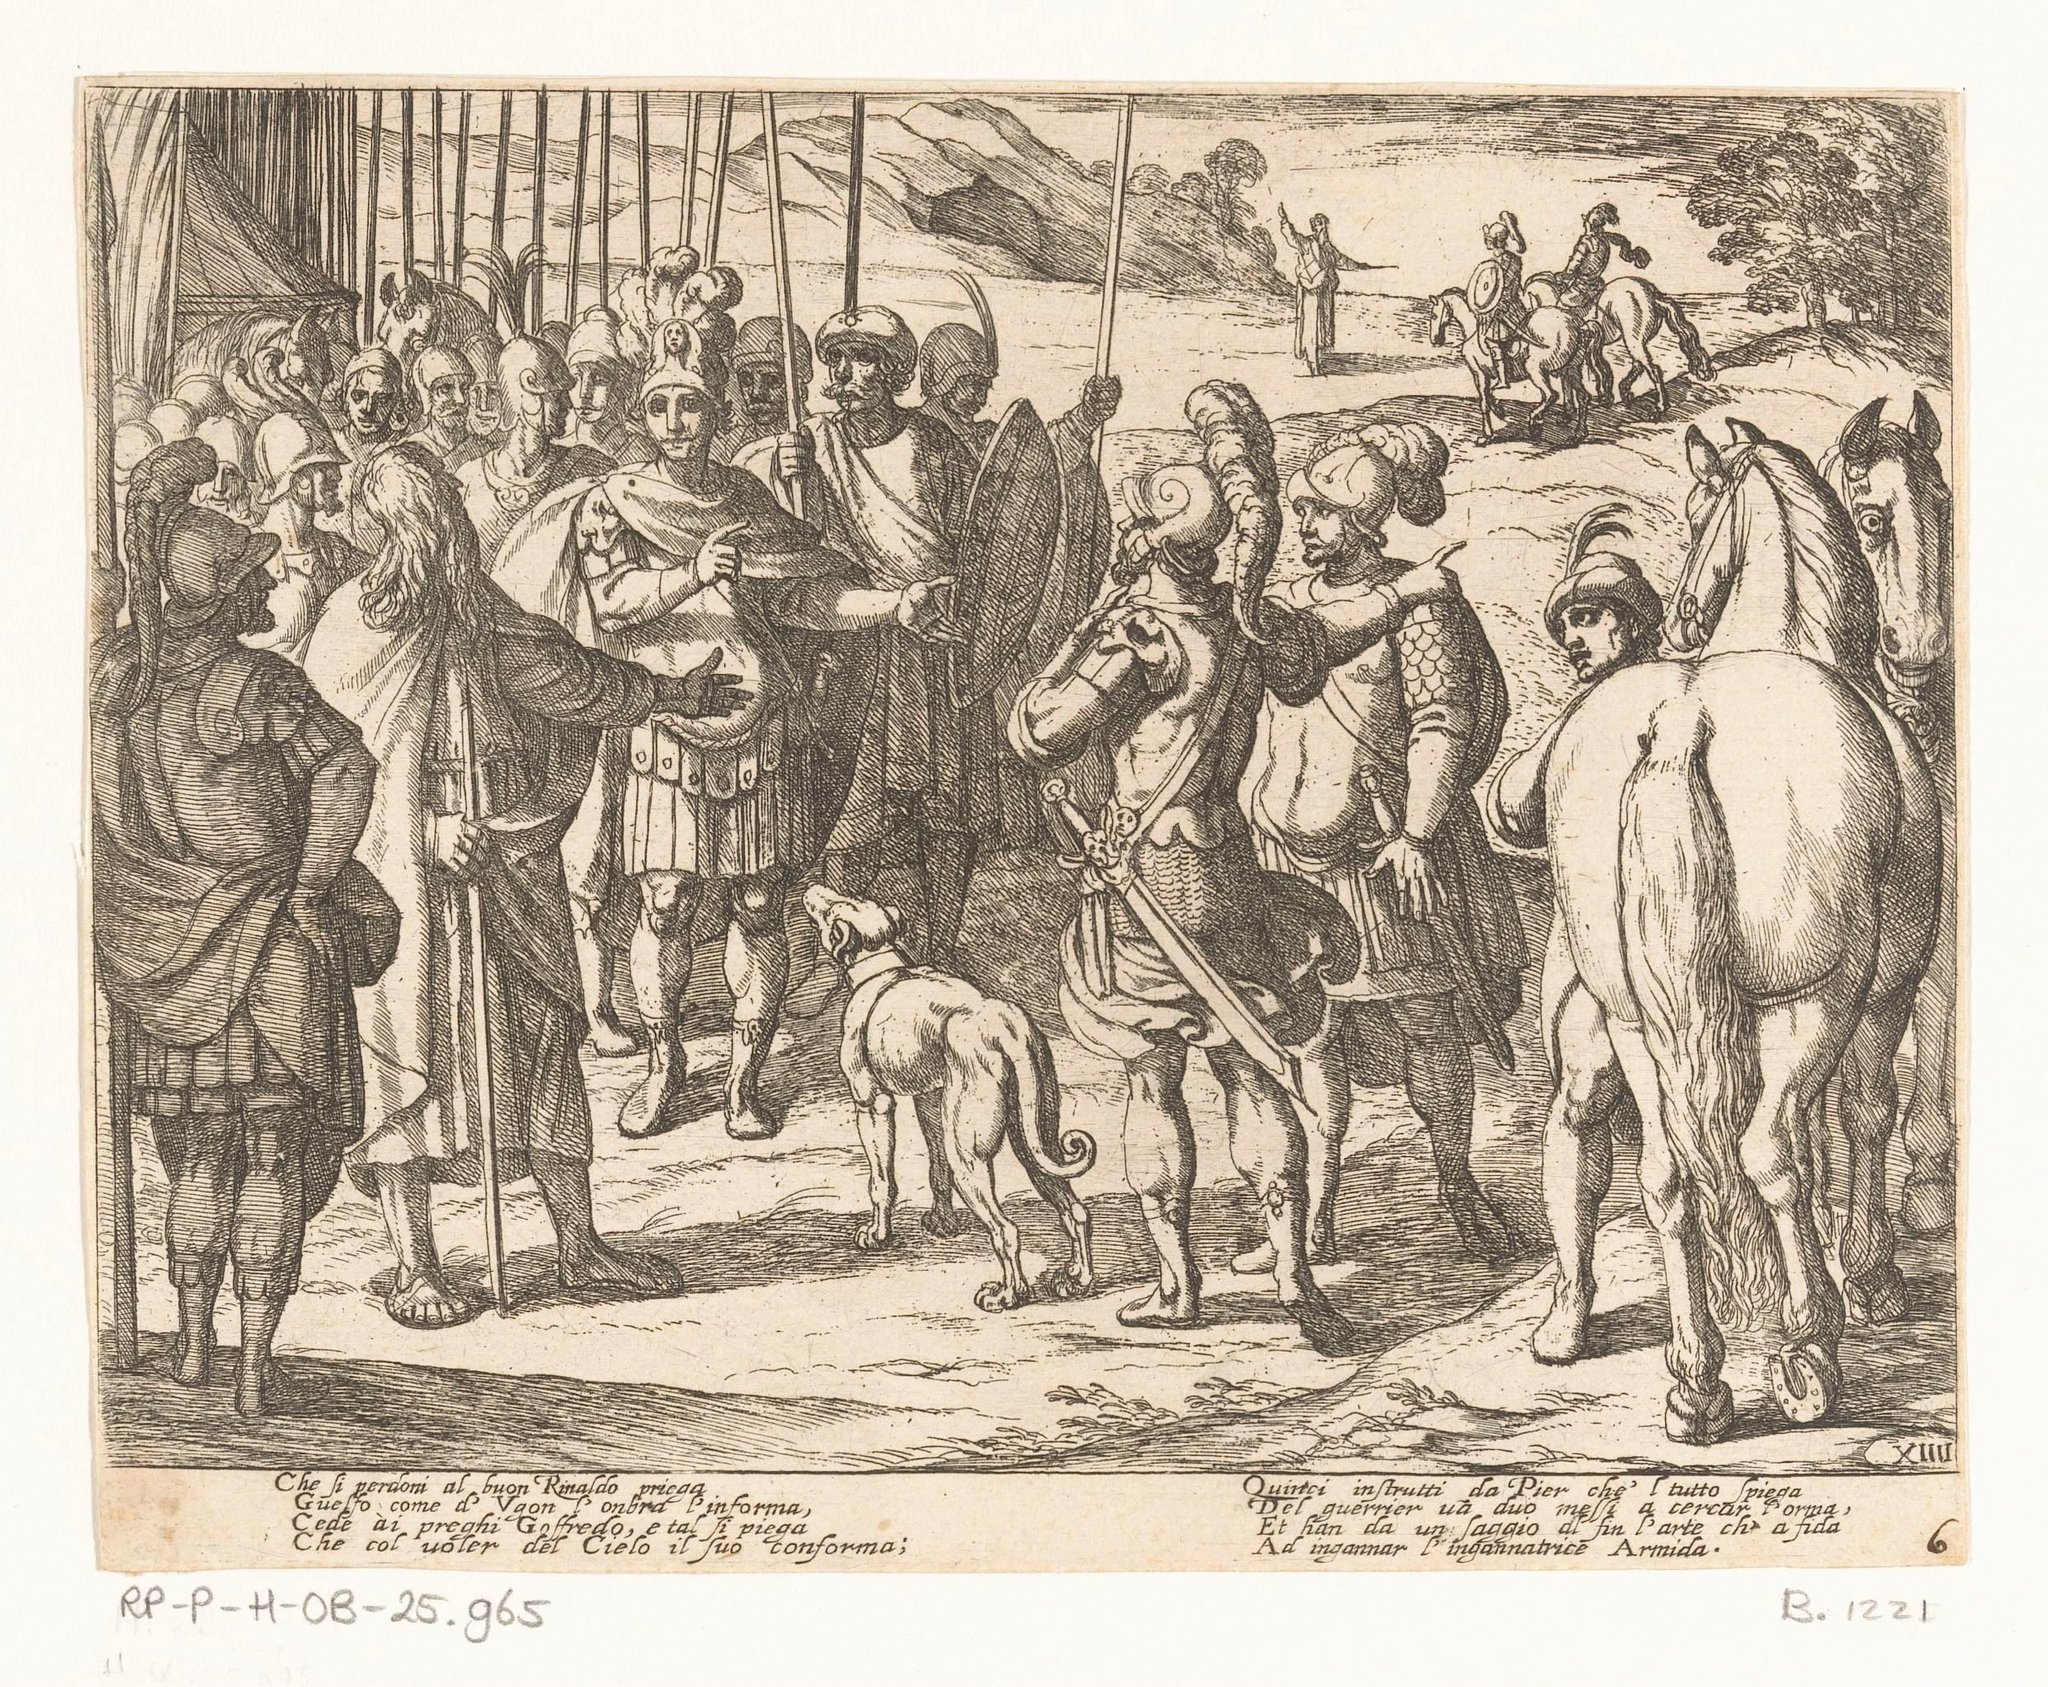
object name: print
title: Jeruzalem verlost (deel 2)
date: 1565-1630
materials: paper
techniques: etching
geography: italy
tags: sorcerer, magician, wizard, warlock, militant proselytizing: religious war, crusade, etc., (scenes from) specific works of literature: tasso, gerusalemme liberata, knight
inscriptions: collector's mark: ‘Hinloopen’, collector's mark: Lugt 11, number: ‘6’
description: Deze prent maakt deel uit van een reeks van twintig prenten (+ opdracht) met voorstellingen van scènes uit Tasso's 'Jeruzalem verlost', een episch gedicht geschreven door de Italiaanse dichter Torquato Tasso en voor het eerst gepubliceerd in 1581. Het verhaal vertelt grotendeels in fictie over de Eerste Kruistocht waarin de christenen, geleid door Godfried van Bouillon, de strijd aangaan met de moslims om het Beleg van Jeruzalem.